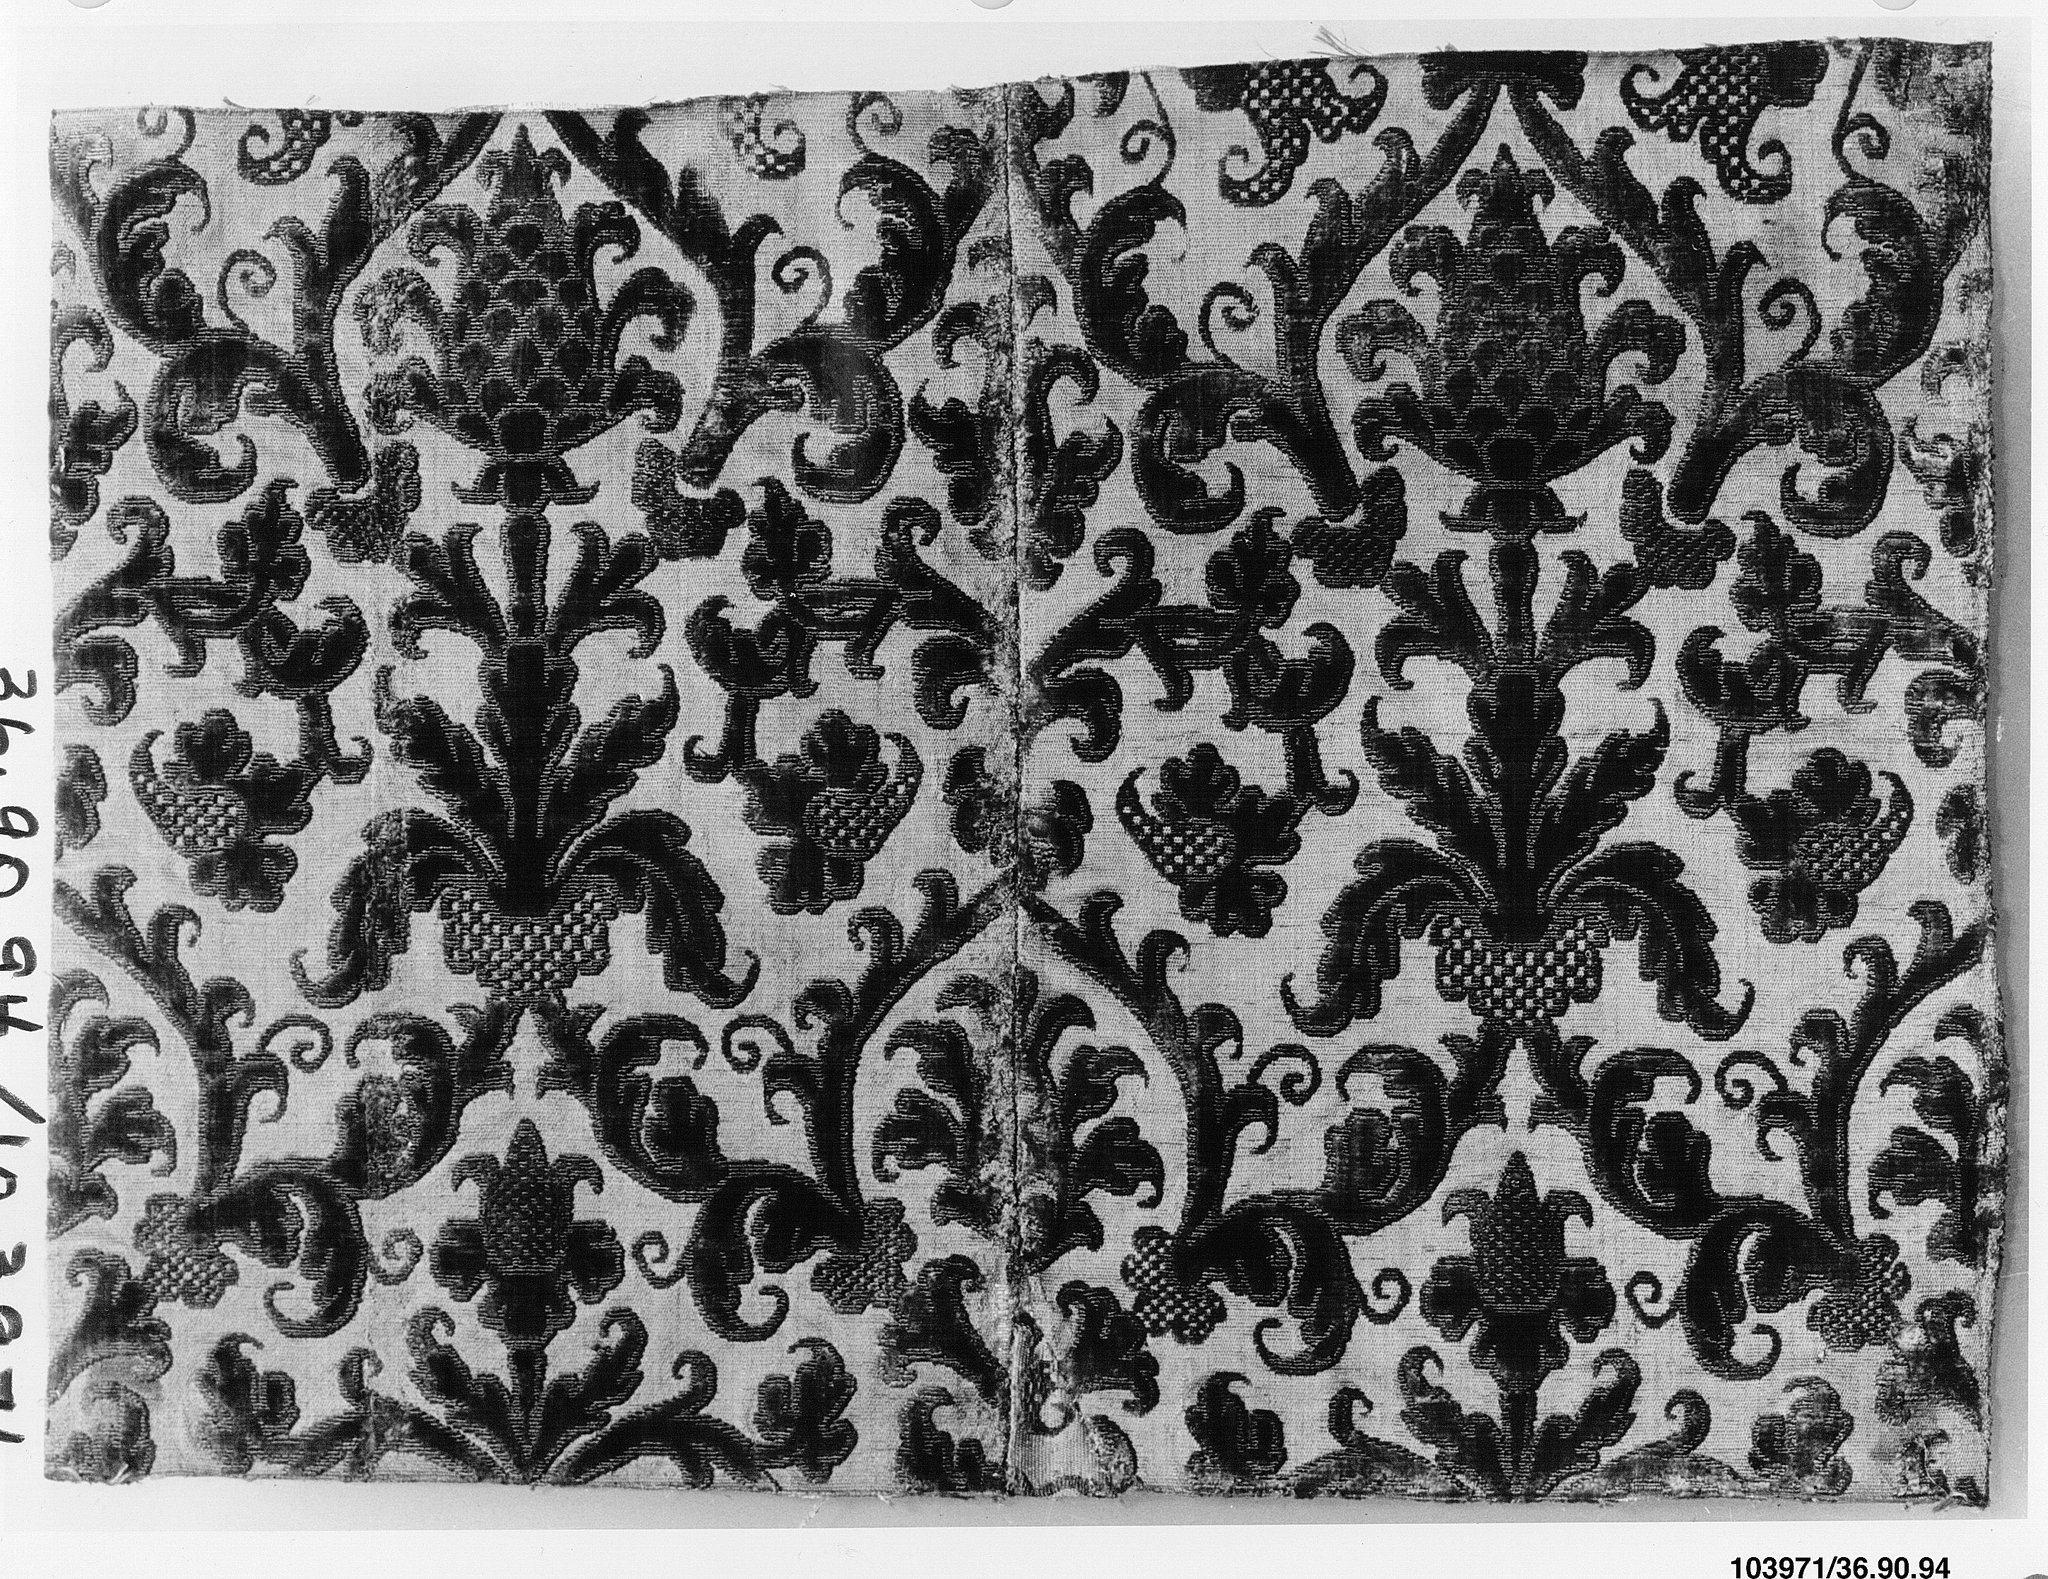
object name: piece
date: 1501-1700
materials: metal thread, silk